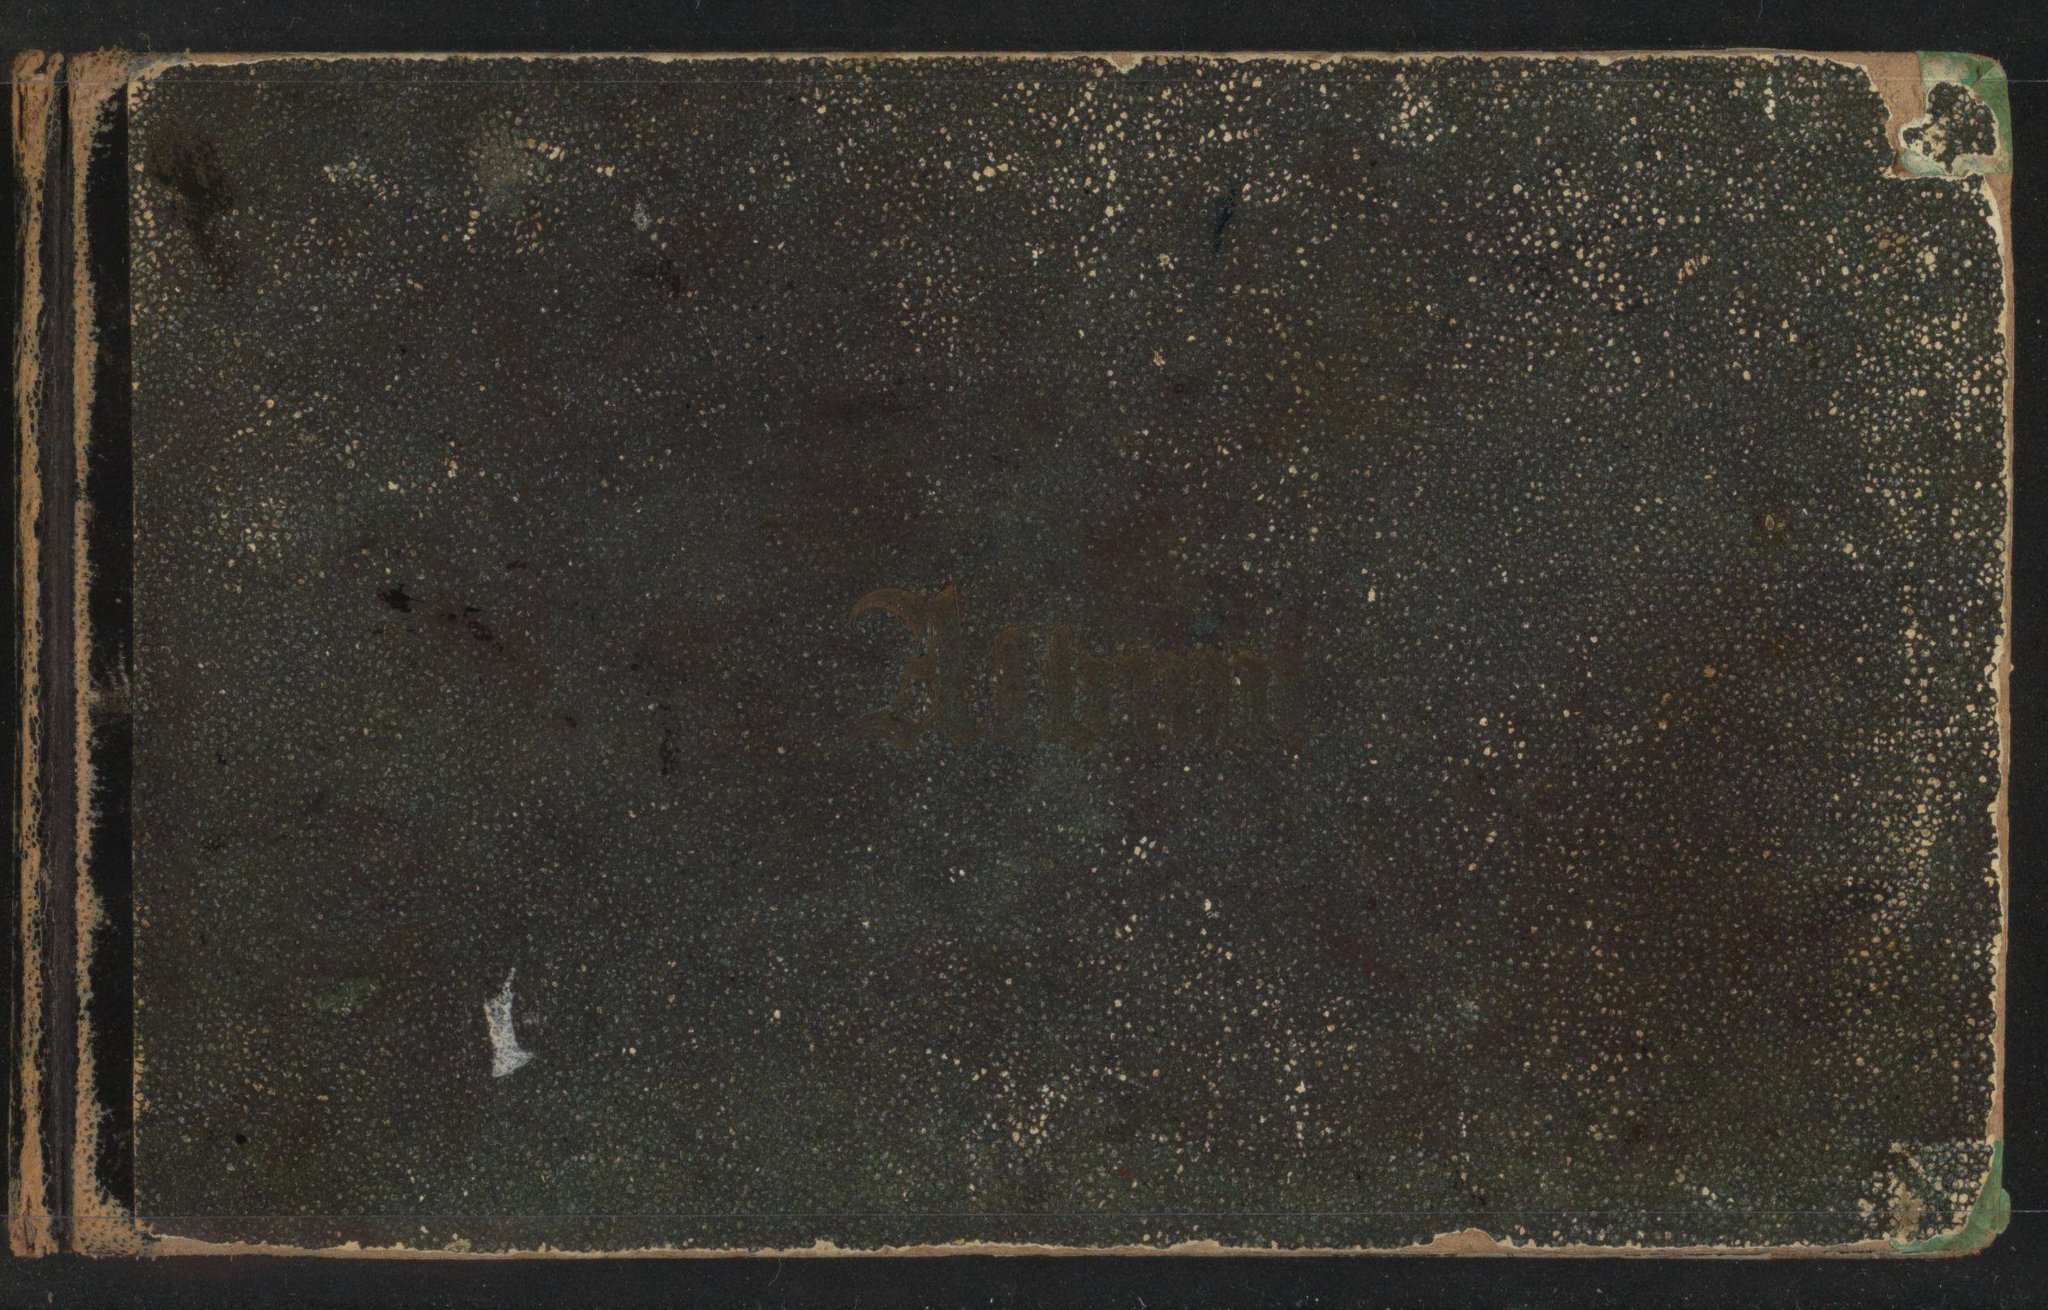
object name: sketchbook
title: Schetsboek met 46 bladen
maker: johannes bosboom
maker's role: draughtsman, painter, print maker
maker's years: 1817-1891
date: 1845-1891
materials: cardboard, chalk, paper, pencil, watercolor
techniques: brush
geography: the hague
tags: city-view, and landscape with man-made constructions, monk(s), friar(s), interior of church, the hague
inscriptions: collector's mark: Lugt 2228a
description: De volgende bladen uit het schetsboek zijn blanco: 3(V), 4(V), 6(V), 11(V), 16(V), 18(V), 23(V), 24(V), 25(V), 26(R), 27(V), 28(R), 34(R), 35(R), 40(R), 41(R), 45(R) en 46(R).